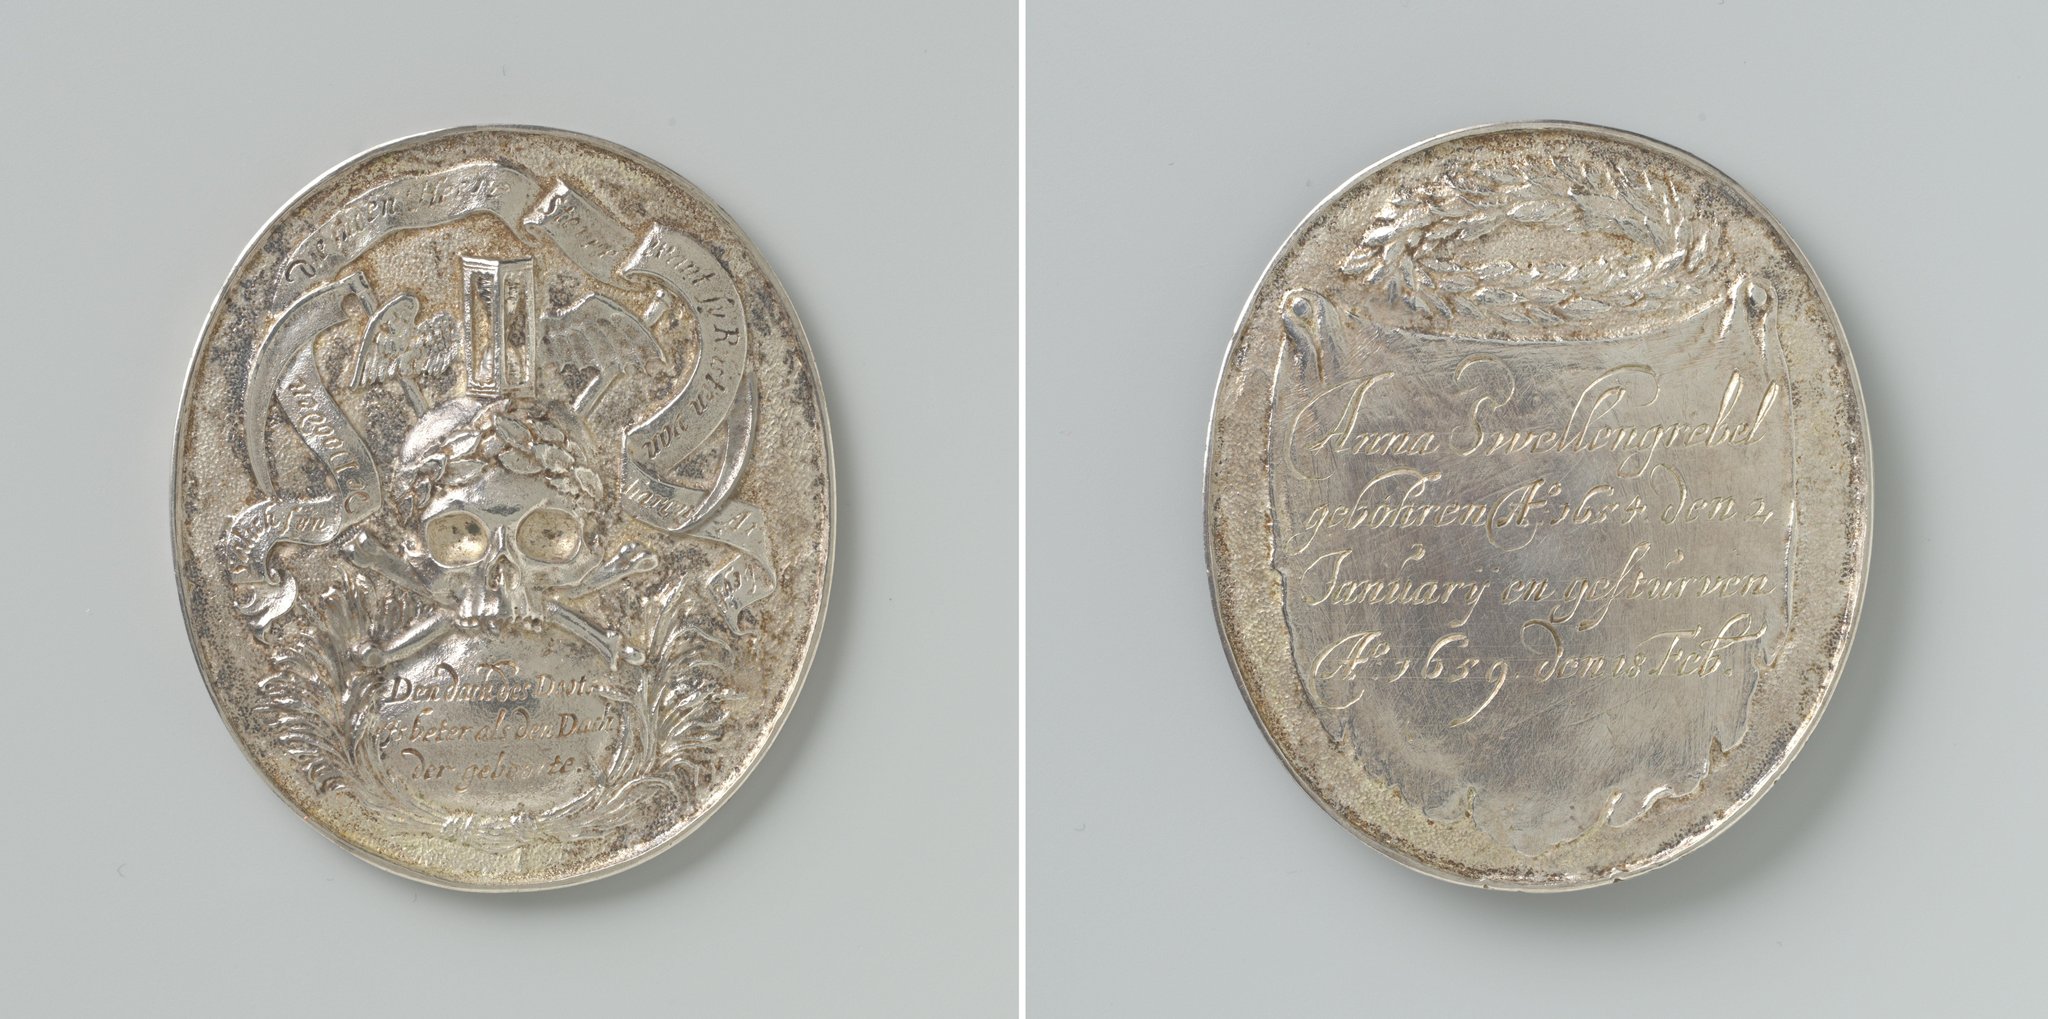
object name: medal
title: Funeral medal of Anna Swellengrebel (1654-1659)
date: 1659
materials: silver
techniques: repoussé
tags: anna swellengrebel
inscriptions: inscription: ‘Anna Swellengrebel / gebohren Ao : 1654 . den 2 / Januarij en gesturven / Ao : 1659 . den 18 Feb .’, inscription: ‘Den dach des Doots / Is beter als den Dach / der geboorte / Salich sijn / de Dooden / die in den Heere / sterve / Want sij Rusten van / haren / Ar . / beijt’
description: Voorzijde: gevleugelde zandloper op gelauwerde schedel, daarachter twee gekruiste beenderen en twee zeisen, omgeven door banderol met tekst. Onderaan een cartouche binnen twee samengebonden takken. Keerzijde: lauwerkrans boven opgehangen doodskleed met opschrift. Anna's ouders waren Hendrick Swellengrebel en Susanna Catharina Ruts.